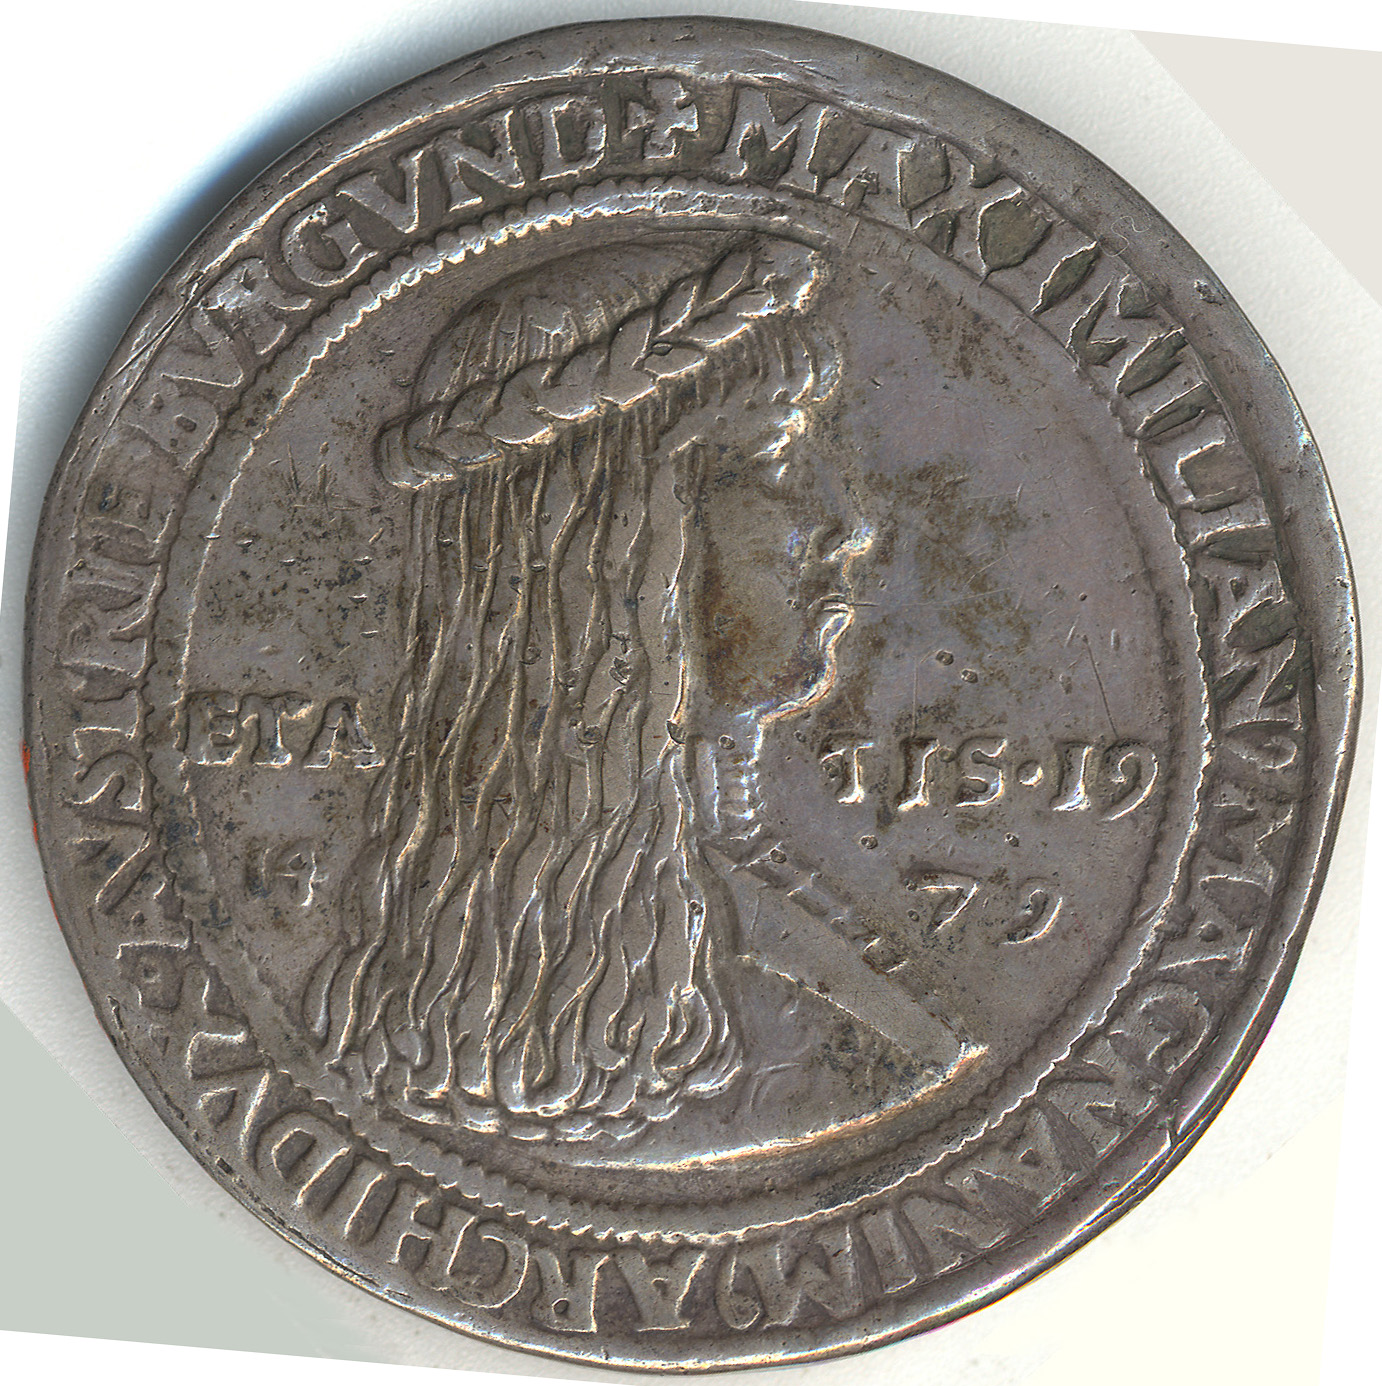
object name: medal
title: Medal of Maximillian I as Archduke Of Austria and Maria of Burgundy, 1479 (?)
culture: european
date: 1501-1533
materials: silver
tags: profiles